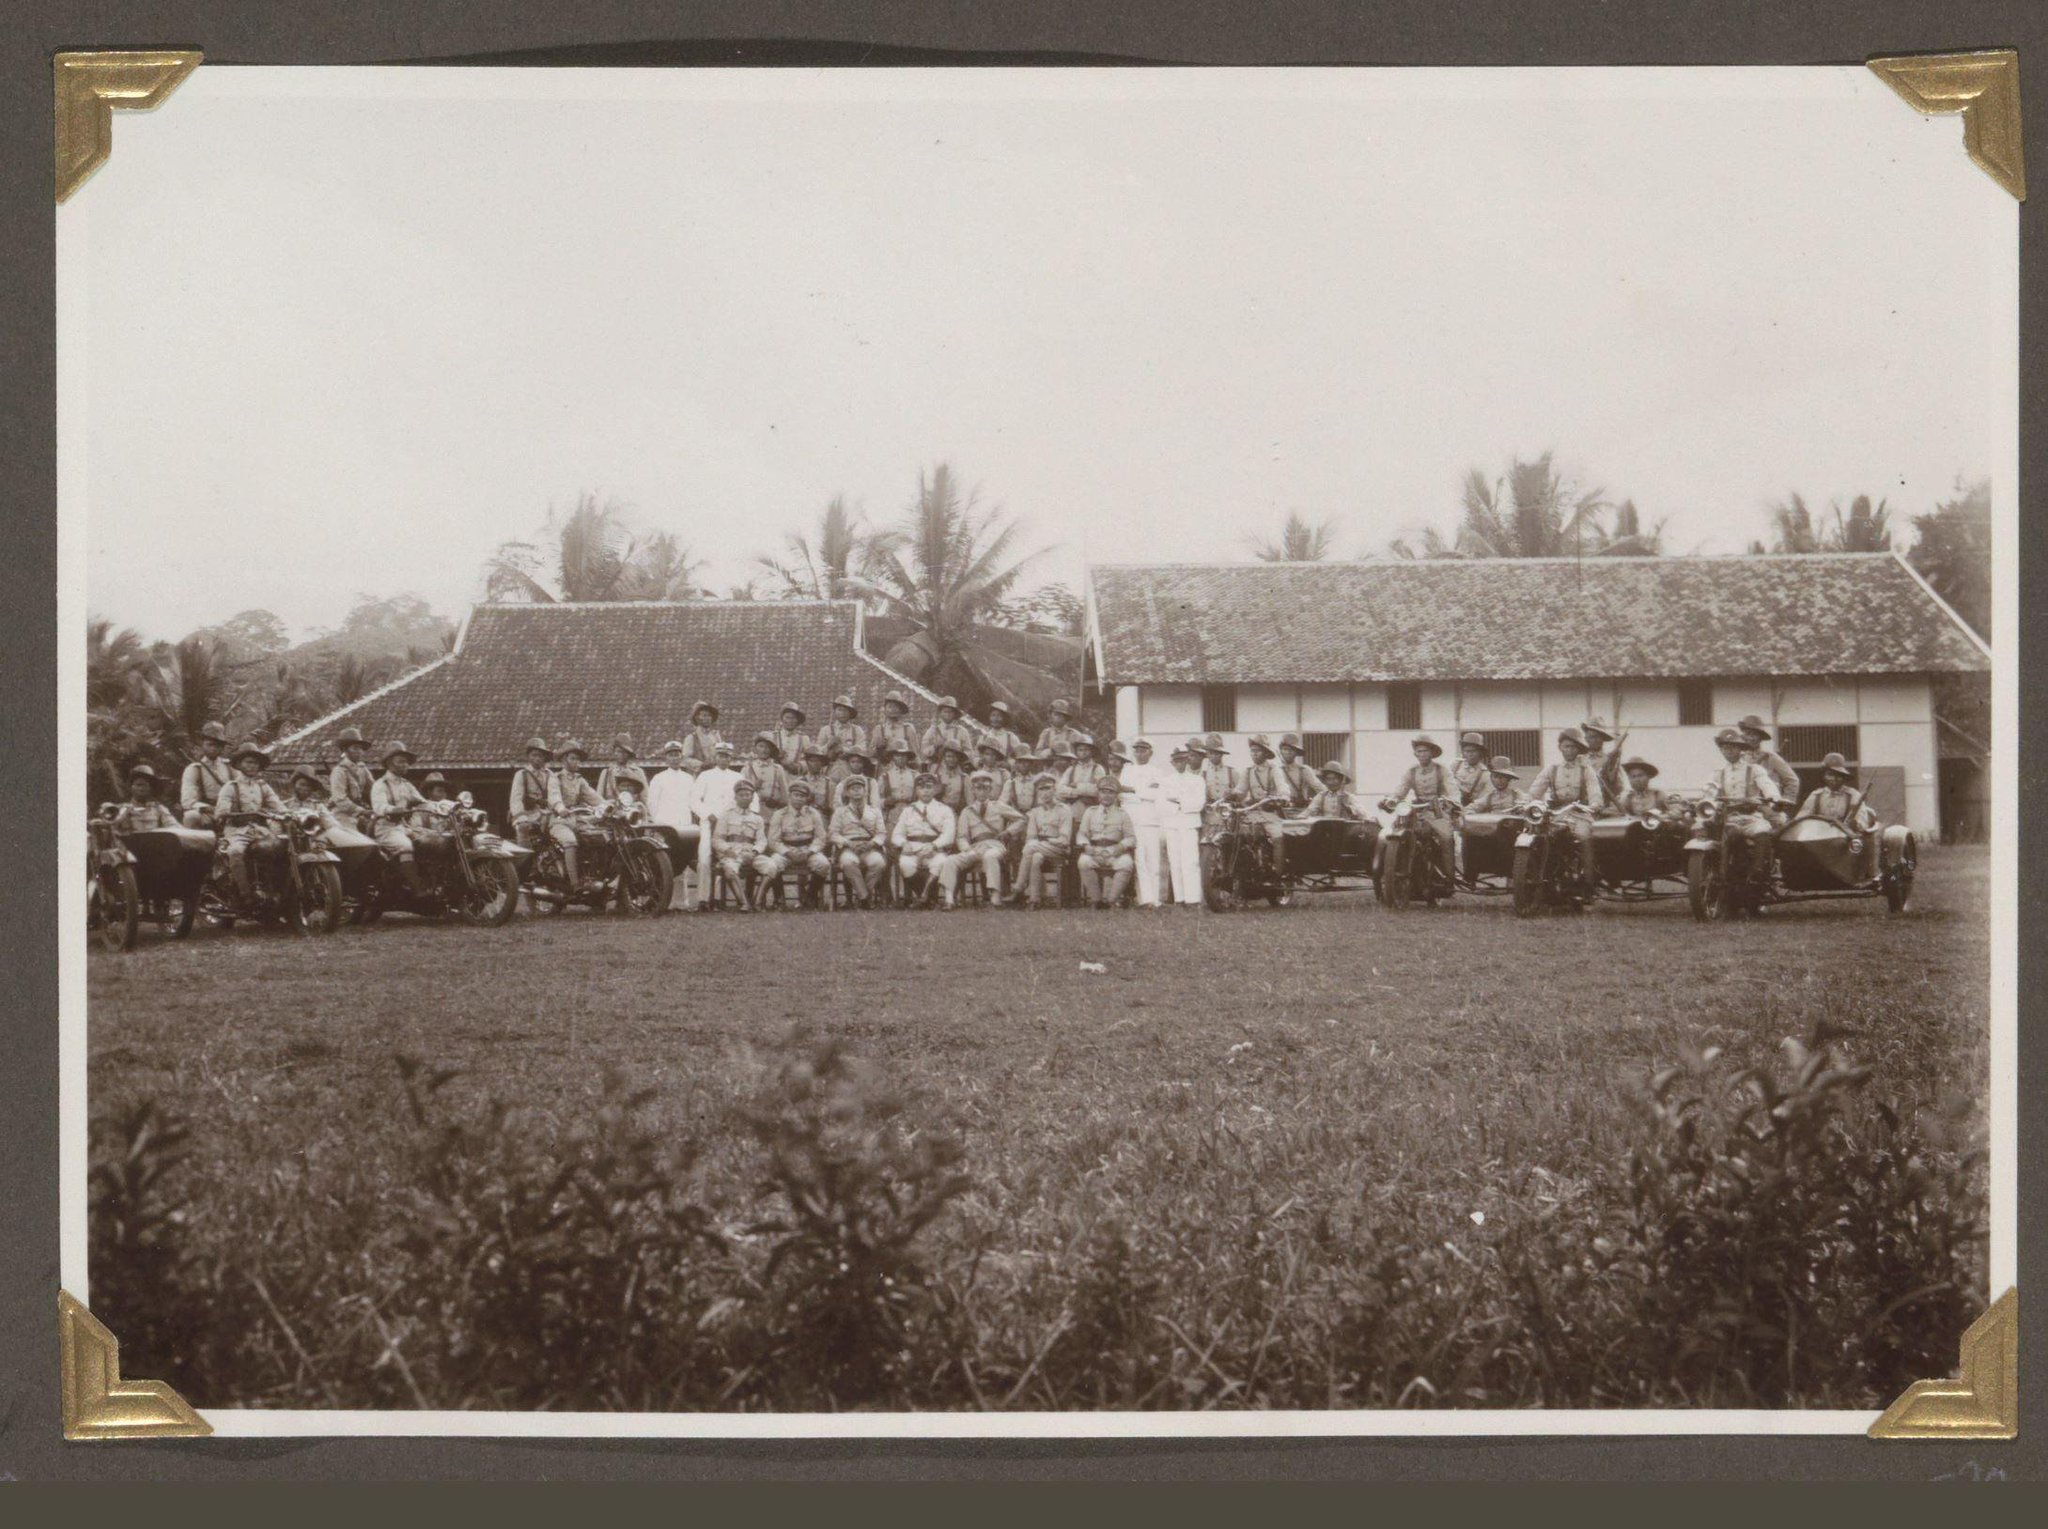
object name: photograph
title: Groepsportret van kader en motoragenten van de politie in Lampong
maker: Anonymous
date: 1932-1933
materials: photographic support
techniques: gelatin silver print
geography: lampung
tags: motor-cycles and other two-wheeled motor-vehicles, police, sumatra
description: Onderdeel van Herinneringsalbum voor F.J. Junius, vertrekkend resident van Lampong (Zuid-Sumatra).